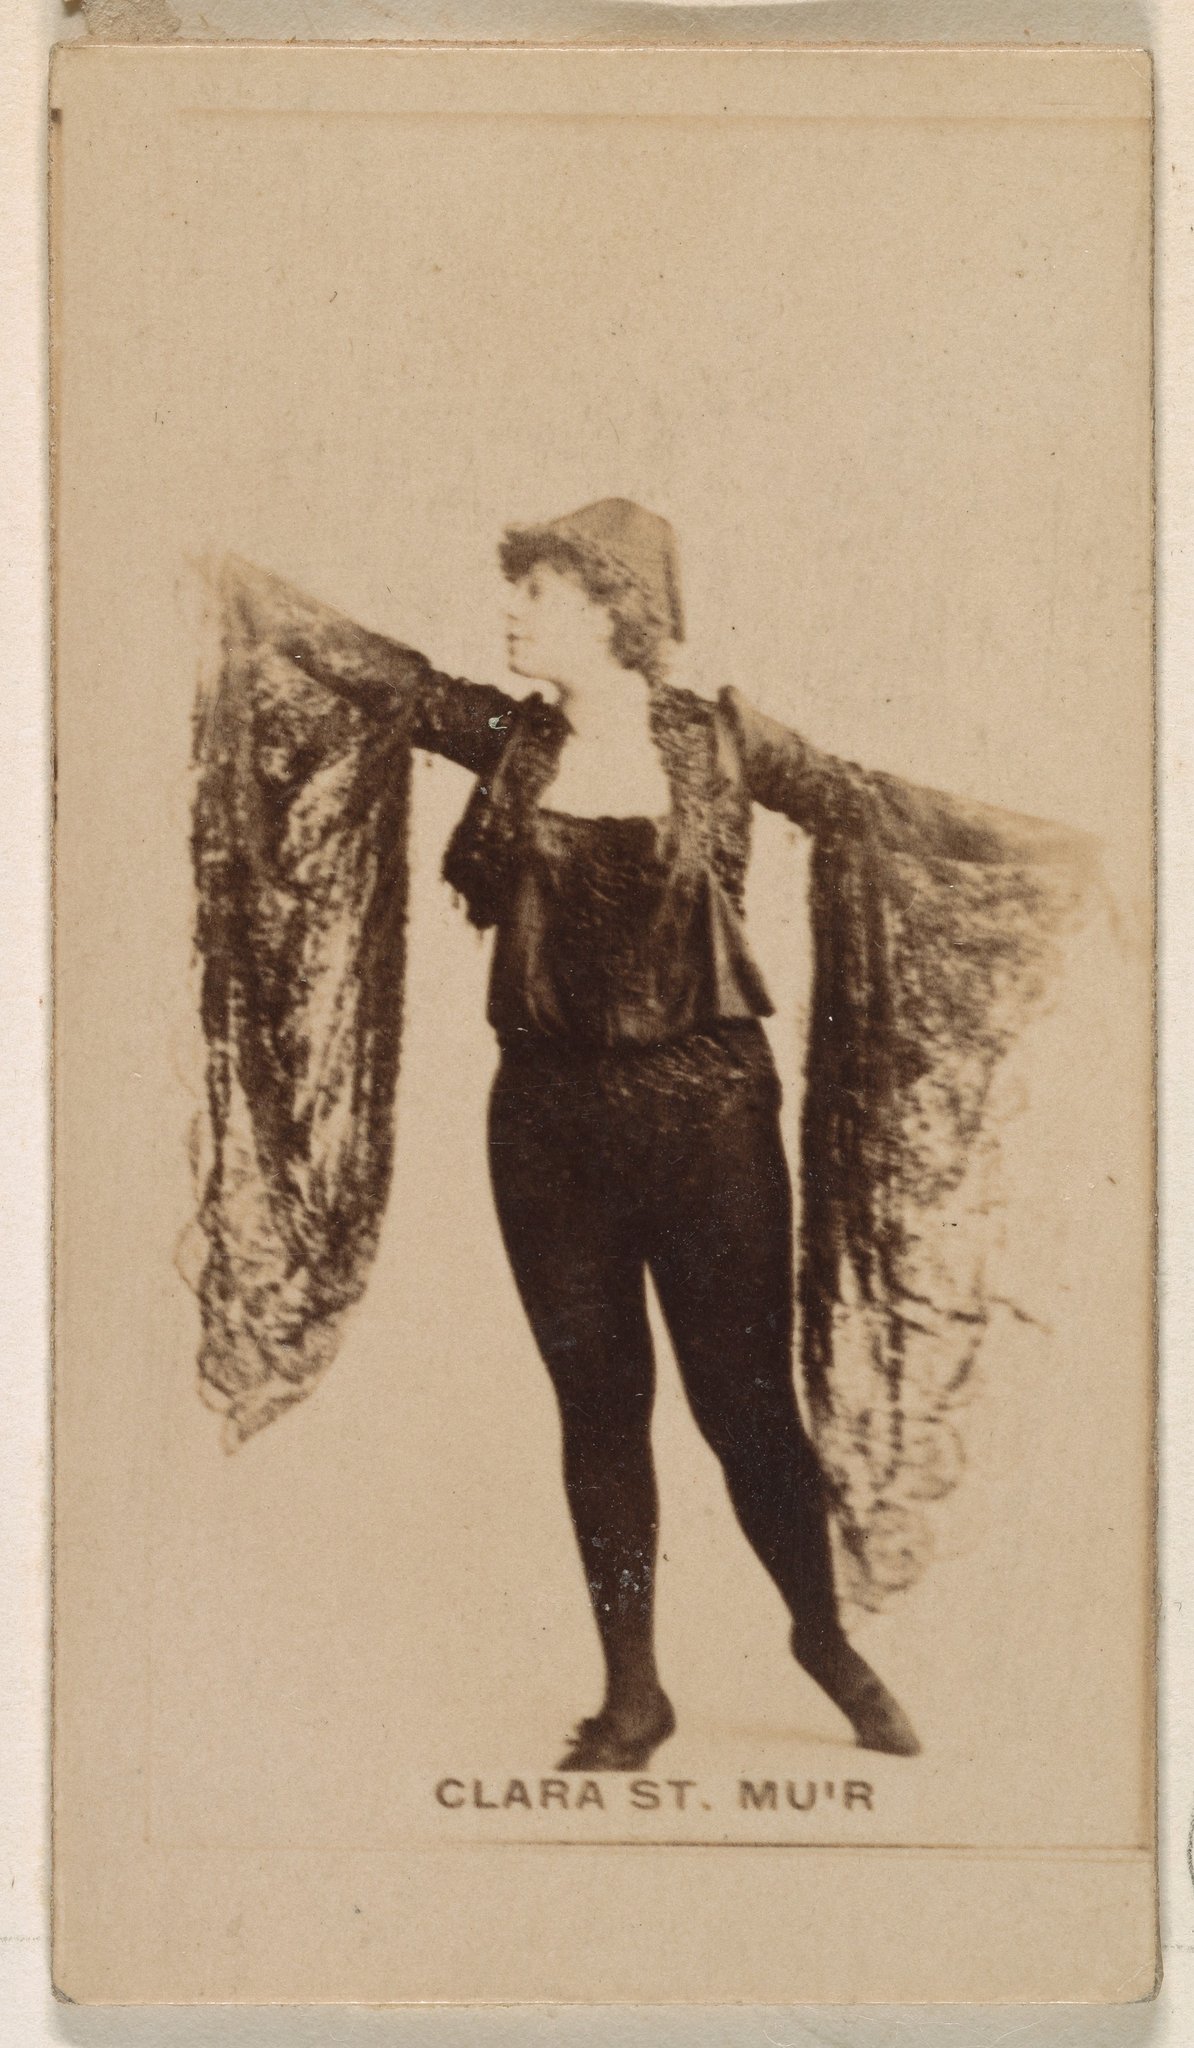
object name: photograph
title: Clara St. Muir, from the Actresses series (N245) issued by Kinney Brothers to promote Sweet Caporal Cigarettes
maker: kinney brothers tobacco company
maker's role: publisher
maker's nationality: american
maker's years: 1869-2011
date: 1890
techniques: albumen silver print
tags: women,actresses